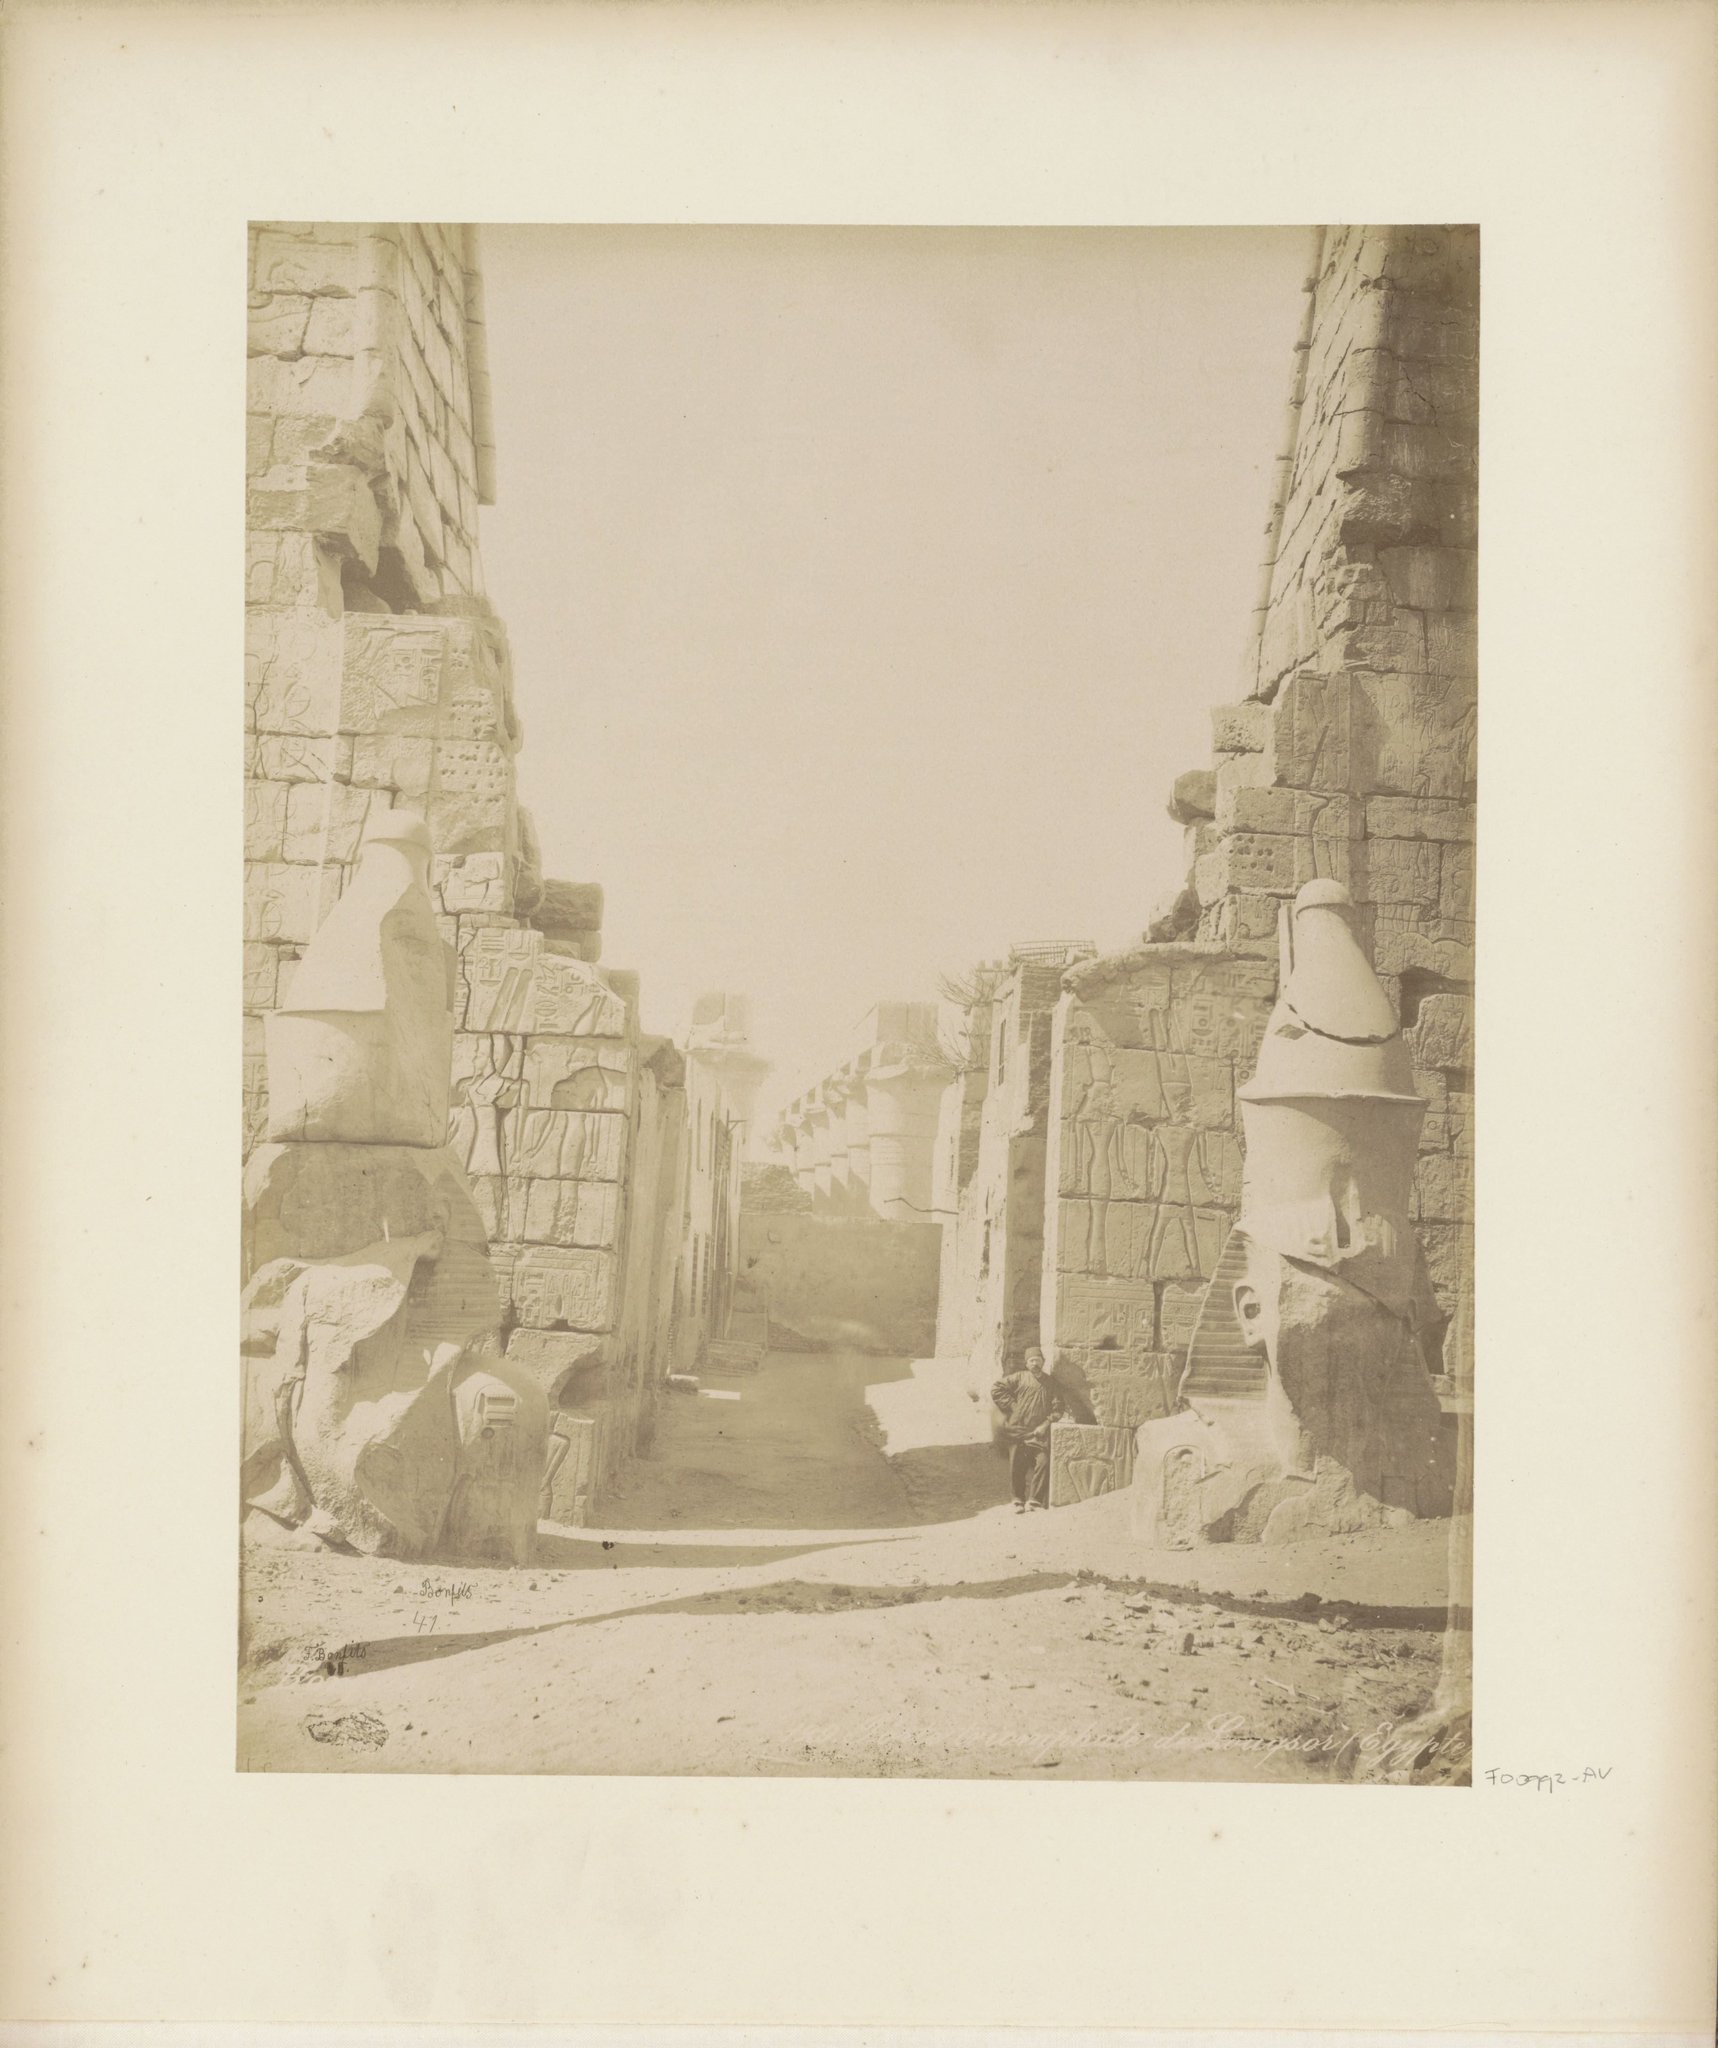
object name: photograph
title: Tempel van Luxor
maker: félix bonfils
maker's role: fotograaf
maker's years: 1831-1885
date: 1898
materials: cardboard, paper, photographic support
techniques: albumen print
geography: luxor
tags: gate, entrance, piece of sculpture, reproduction of a piece of sculpture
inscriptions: number: ‘41’, name: ‘Bonfils / F. Bonfils’, negative number: ‘129’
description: Onderdeel van Reisalbum met 80 foto's van Egypte.